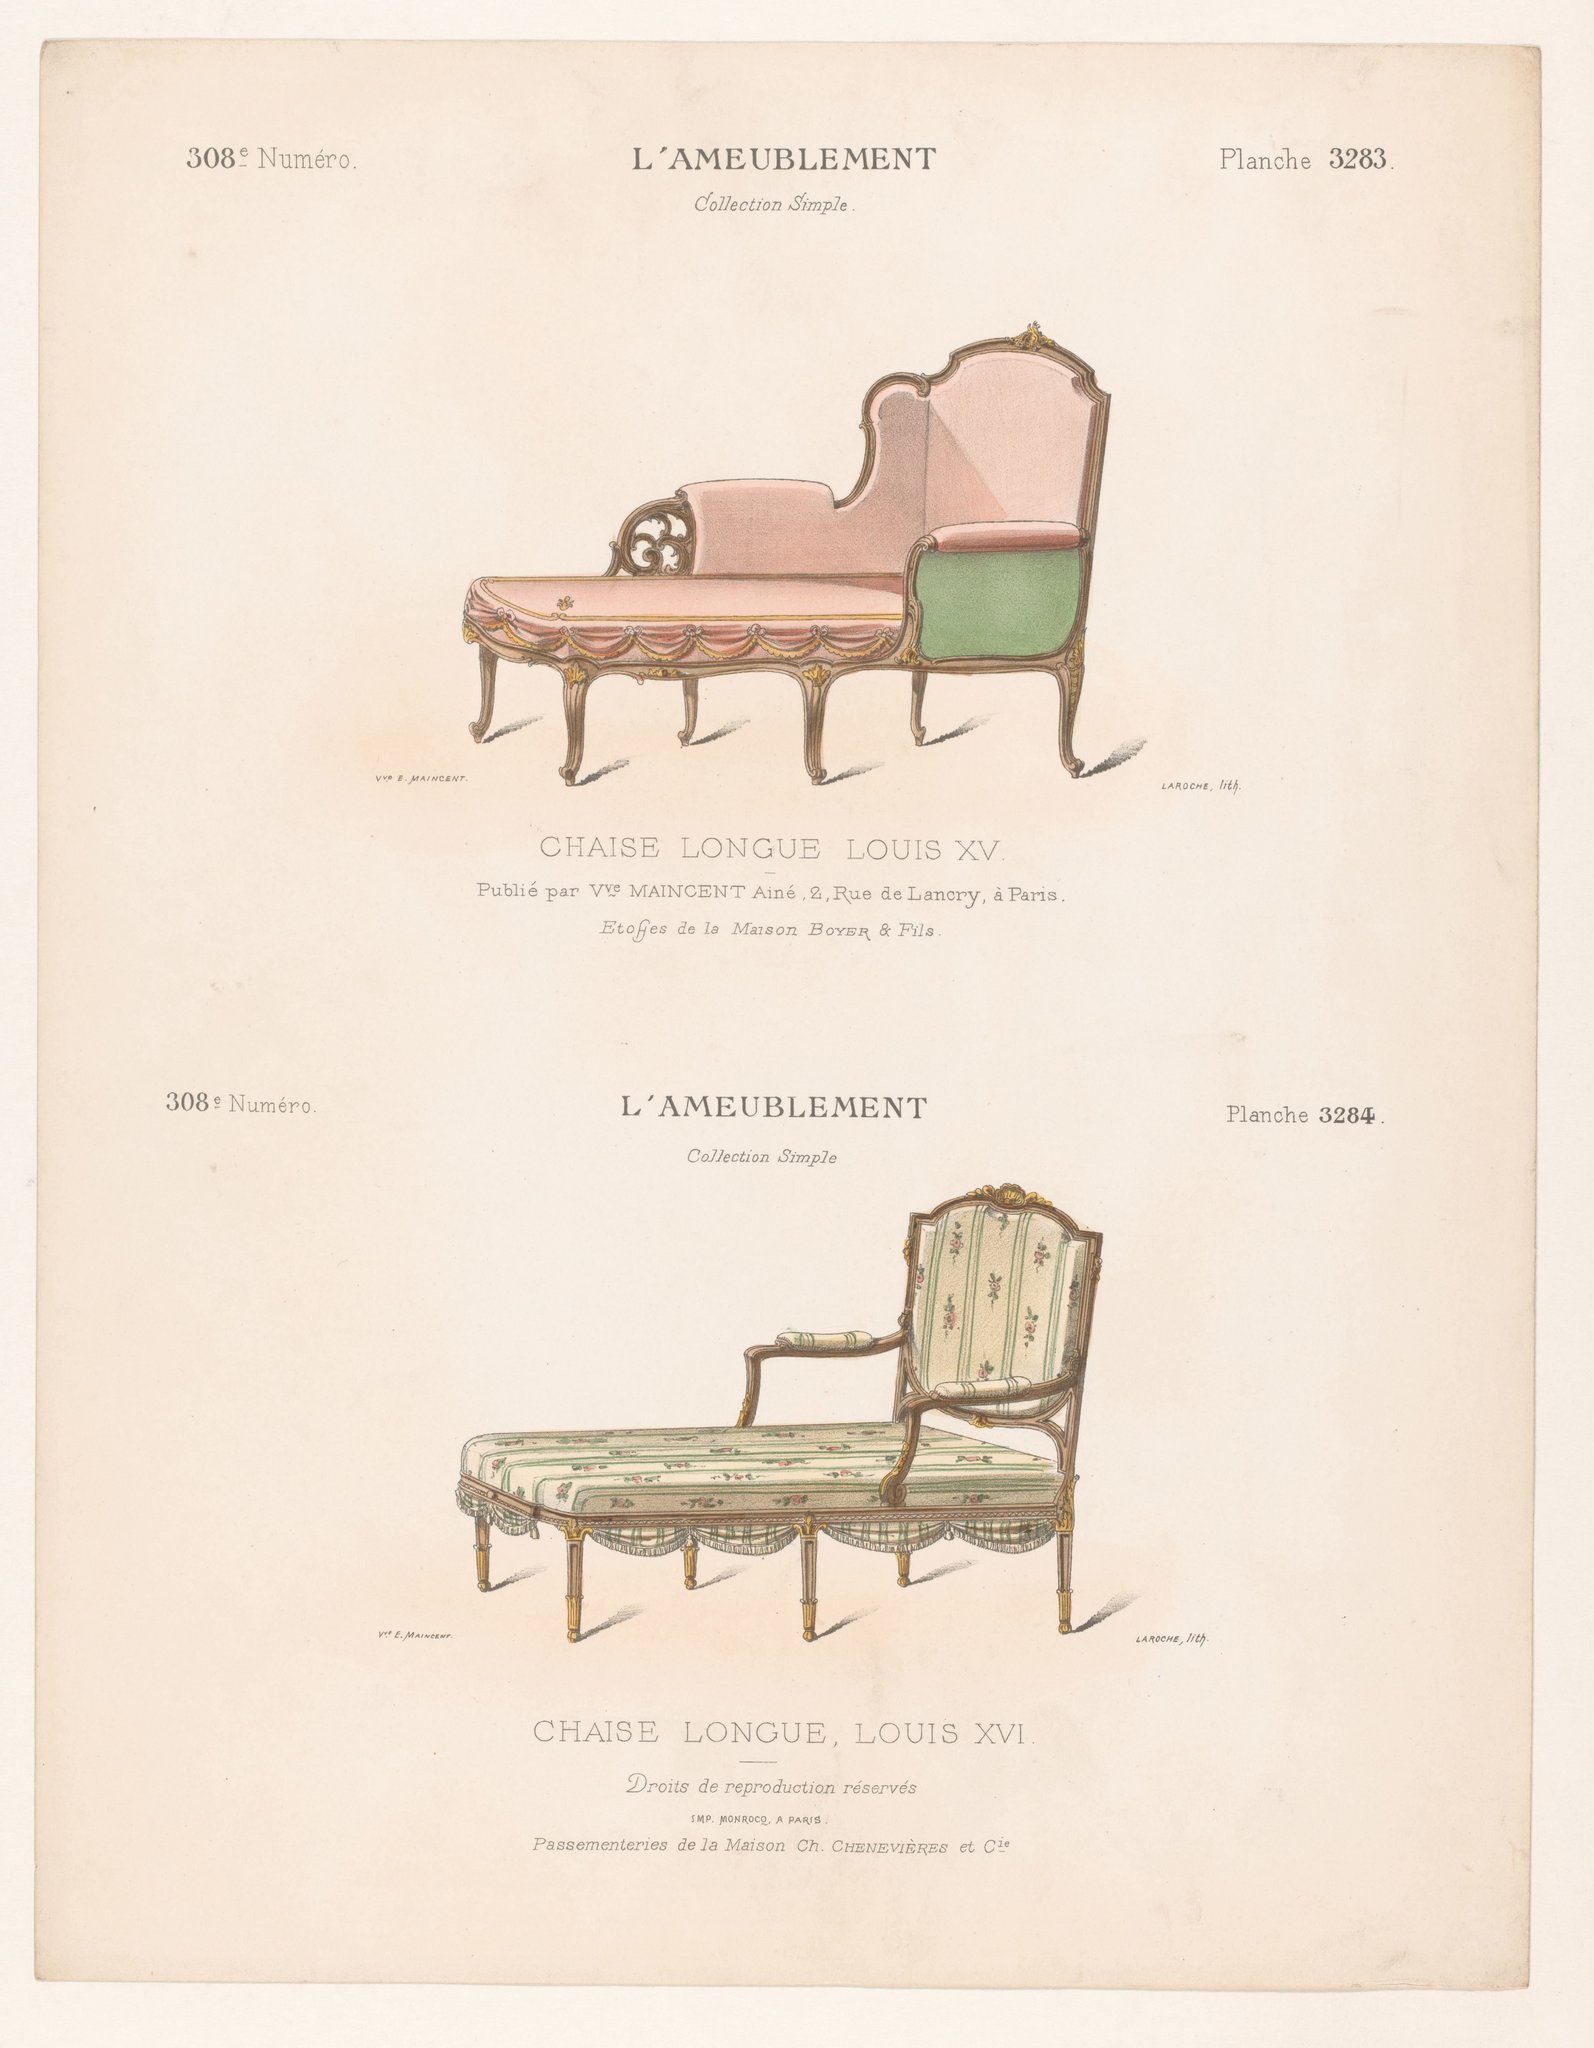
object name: print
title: Chaise longue Louis XV / Chaise longue, Louis XVI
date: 1895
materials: paper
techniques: hand coloring, lithograph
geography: paris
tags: seating furniture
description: Twee chaise longues in de stijlen van Lodewijk XV en Lodewijk XVI. Prent uit 308e nummer (livraison).